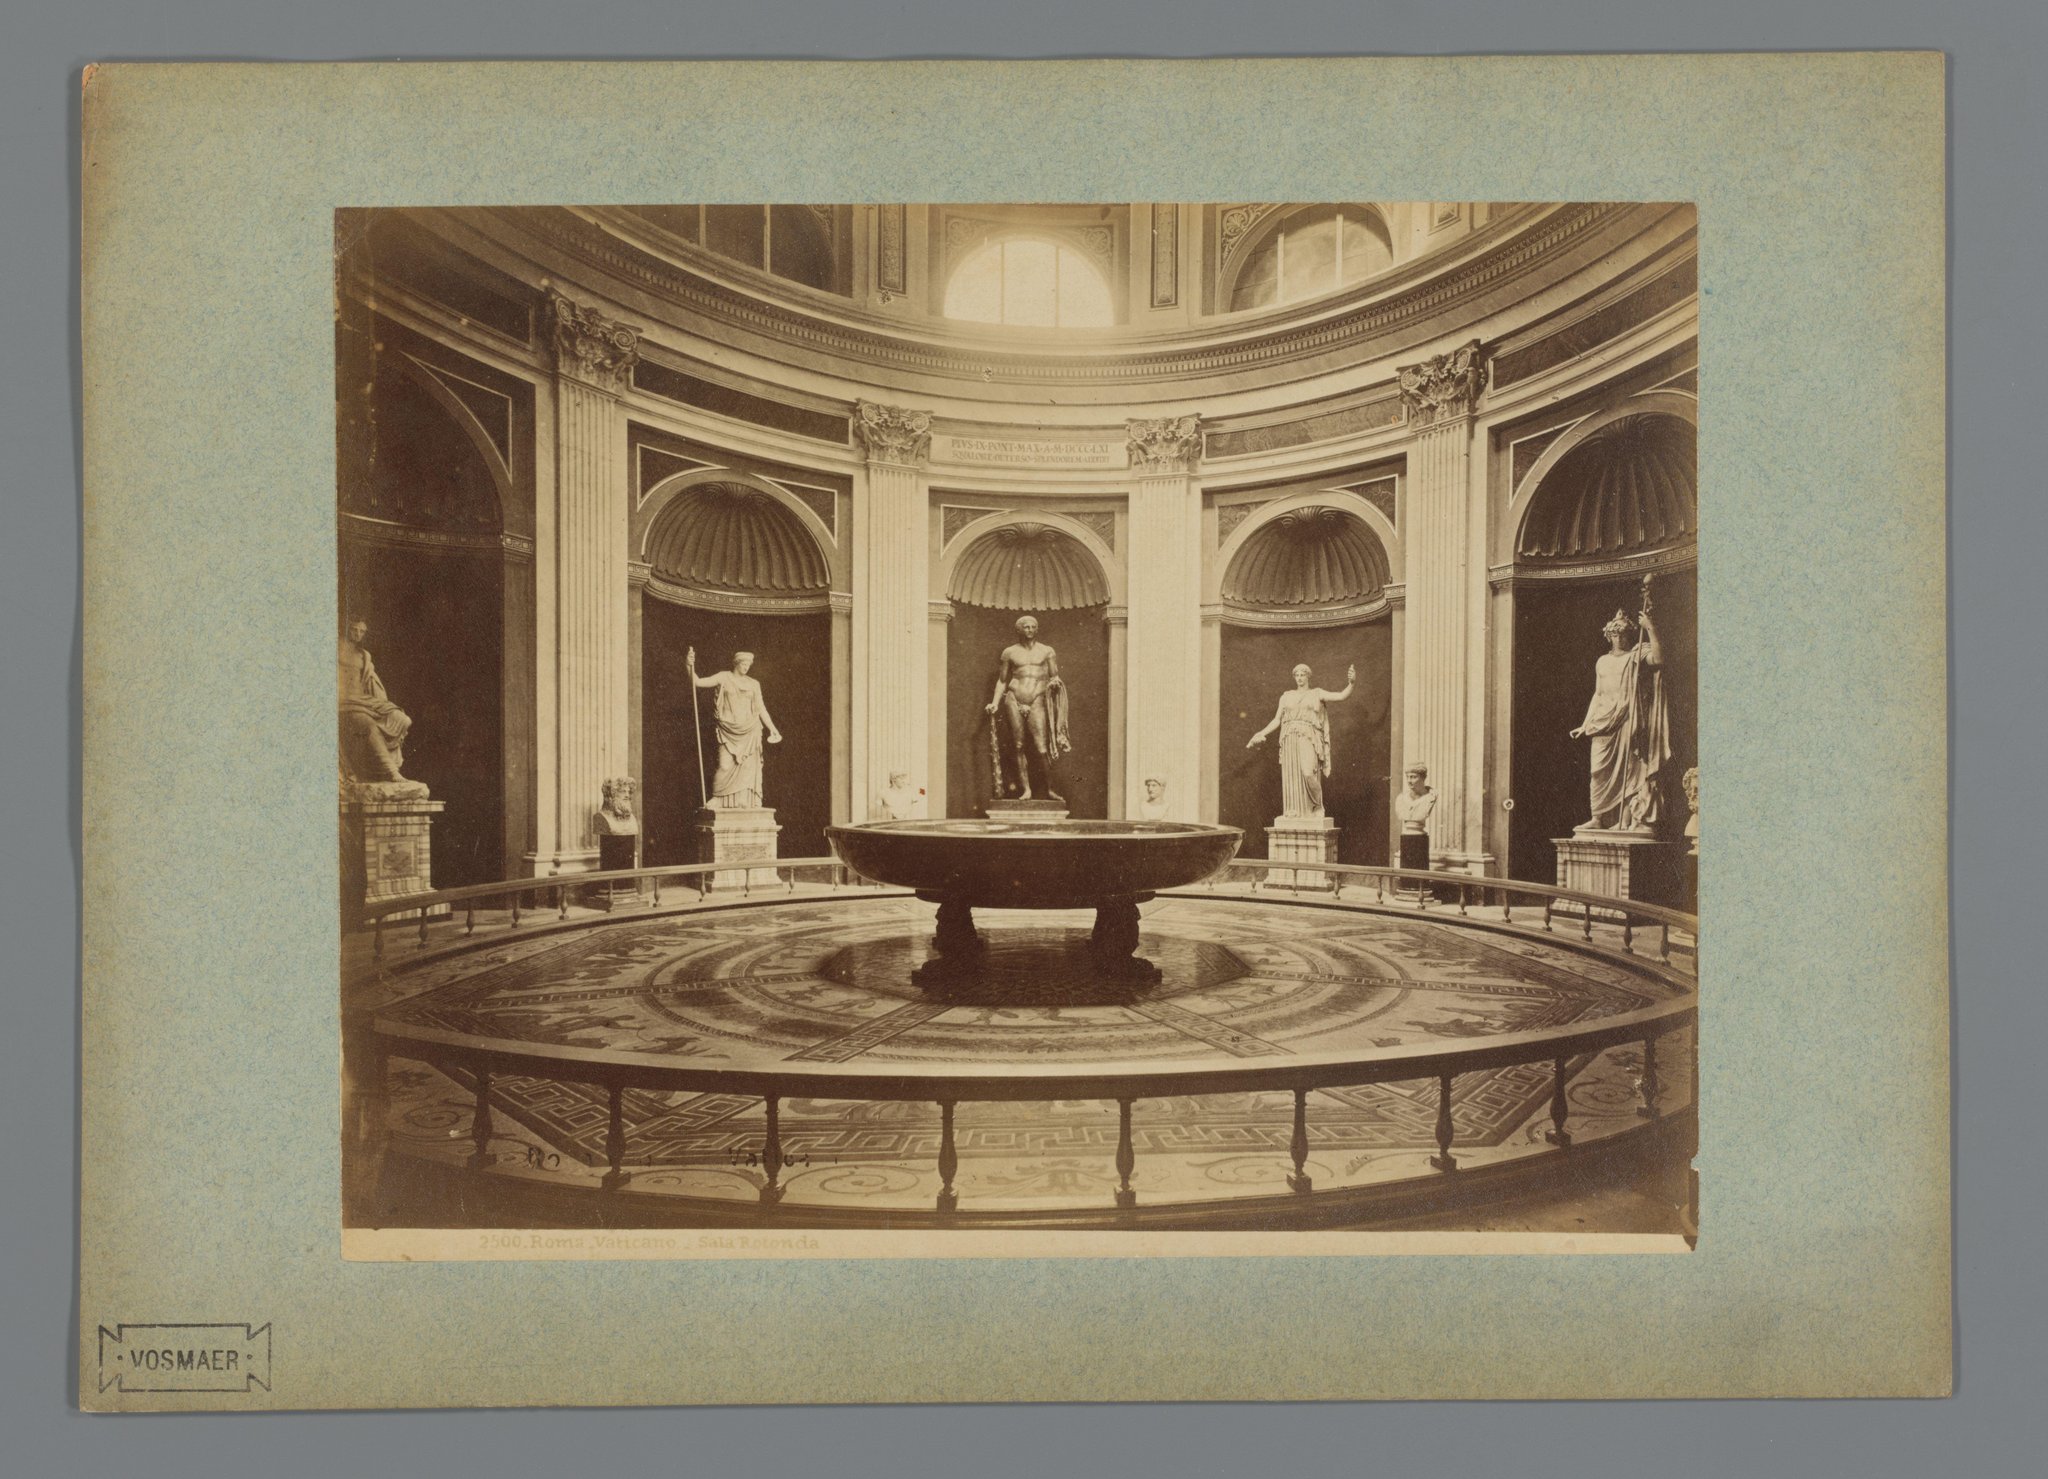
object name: photograph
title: Roma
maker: Anonymous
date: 1851-1890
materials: cardboard, paper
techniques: albumen print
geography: rome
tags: gallery of sculptures, interior ~ representation of a building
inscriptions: collector's mark: ‘VOSMAER’, number: ‘2500.’